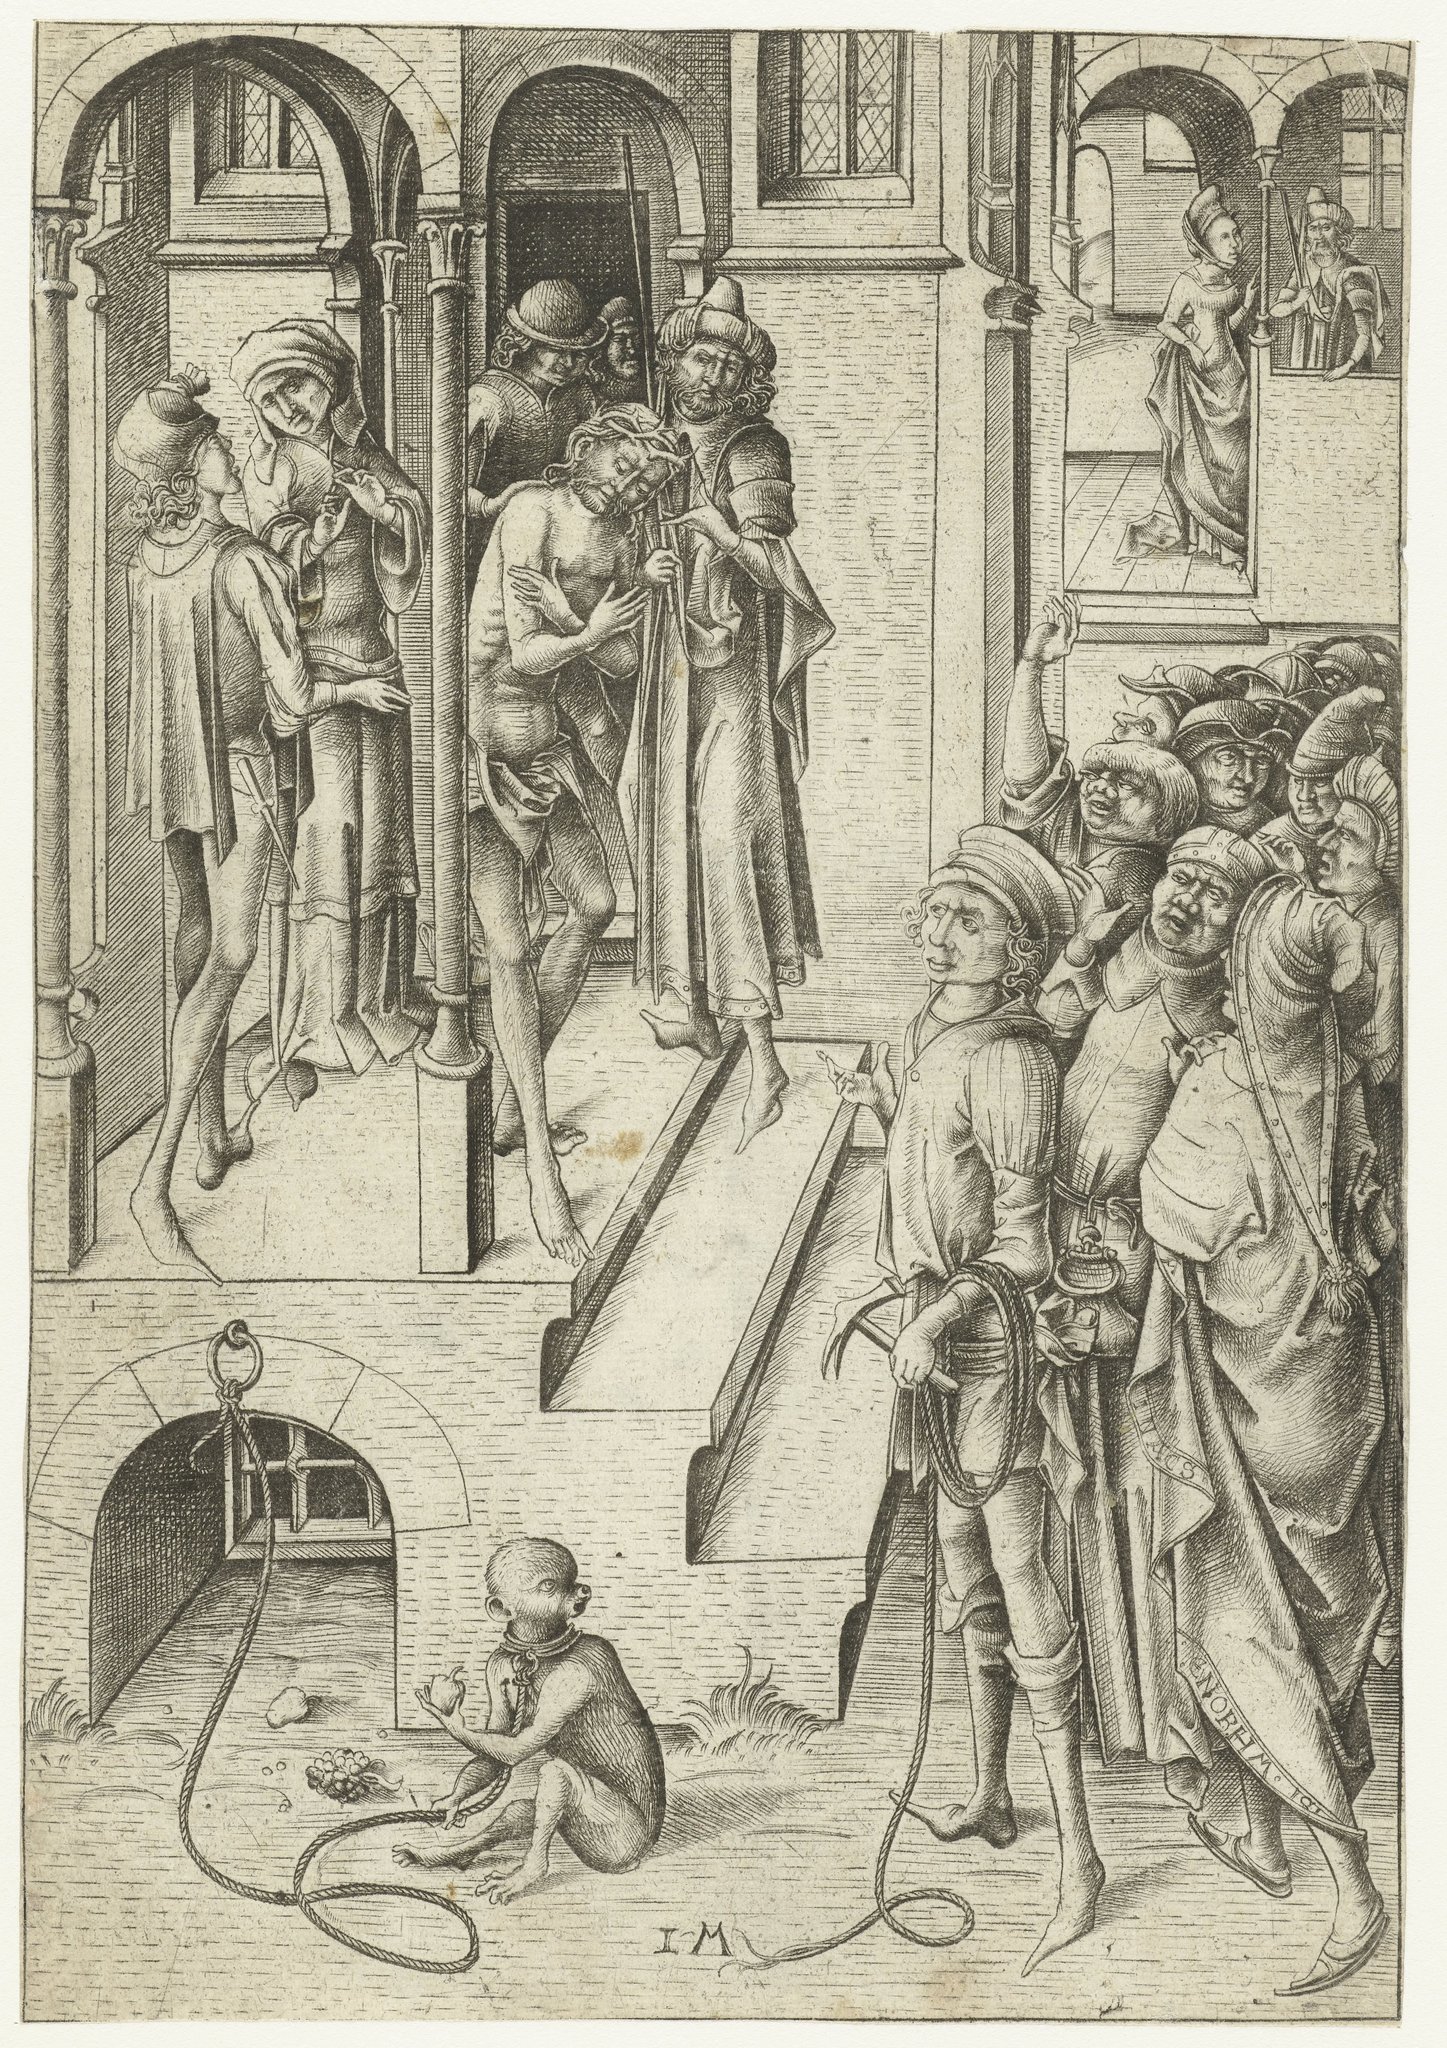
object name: print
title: De Passie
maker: israhel van meckenem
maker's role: print maker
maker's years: 1440-1517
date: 1455-1503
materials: paper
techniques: engraving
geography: bocholt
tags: pilate showing christ to the people, 'ostentatio christi', 'ecce homo' (john 19:4-6)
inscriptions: collector's mark: Lugt 2228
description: Christus staat op een bordes voor een joelende menigte mensen. Naast hem staat Pilatus. Op de voorgrond zit een aapje aan een touw. Deze prent is onderdeel van een serie van twaalf prenten met scènes uit het Lijdensverhaal.